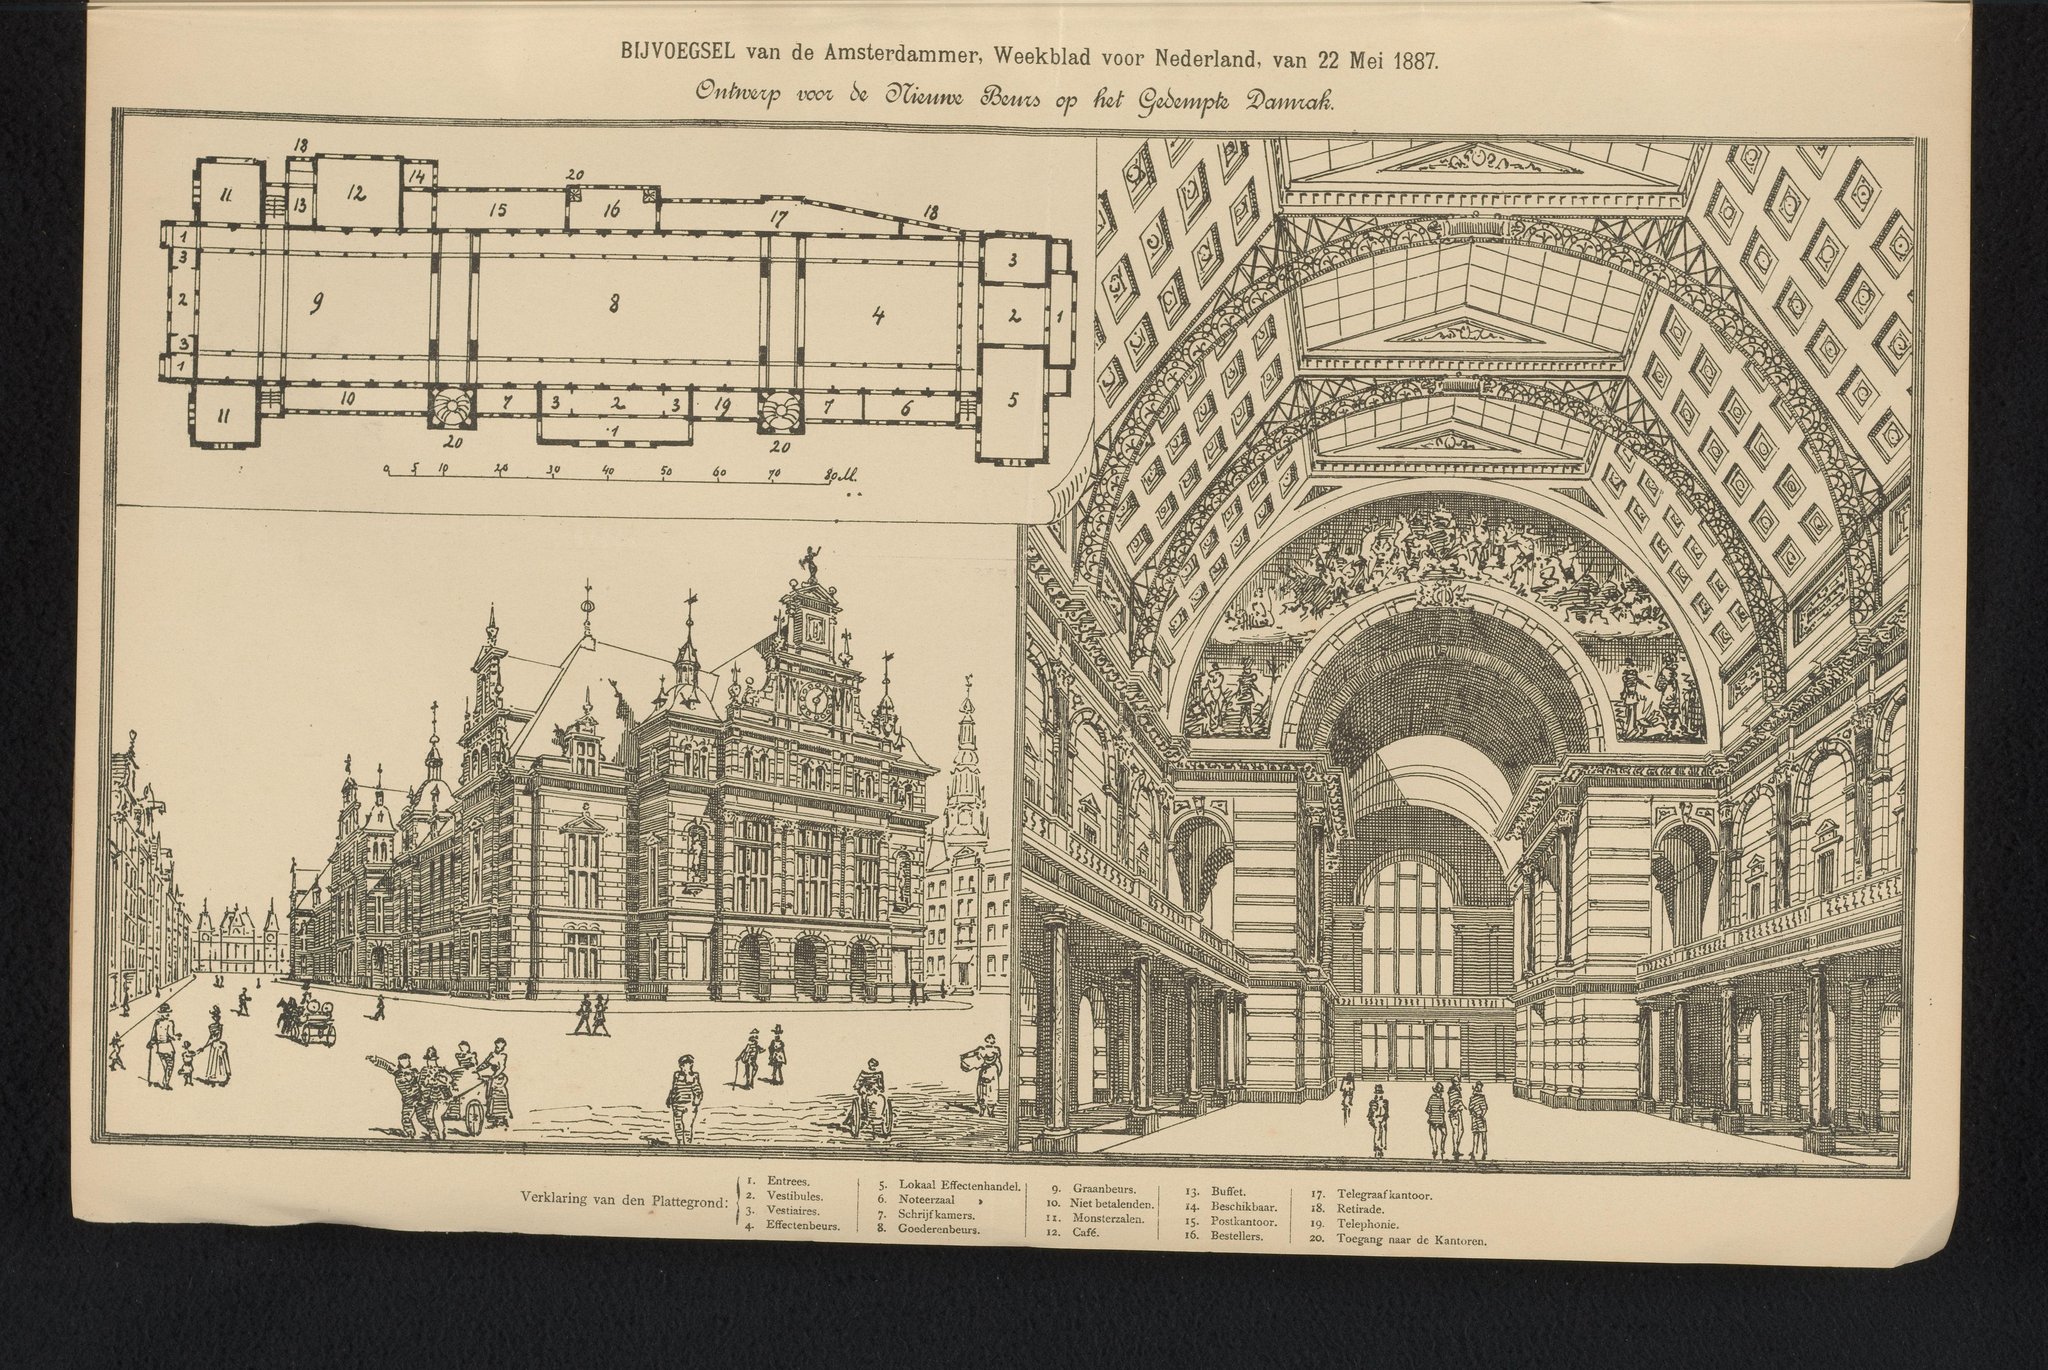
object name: print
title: Ontwerp voor de Nieuwe Beurs op het Gedempte Damrak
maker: Anonymous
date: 1887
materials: paper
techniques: lithograph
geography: amsterdam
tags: stock exchange, stock-market, architectural design or model, plan ~ architecture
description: Het ontwerp van de architecten J.F. Groll en F. Oltmann voor een nieuwe beurs op het Damrak. Gezichten van het exterieur en het interieur en een plattegrond, met onderaan de legenda. Dit niet-uitgevoerde ontwerp won de tweede prijs in de prijsvraag van 1884.